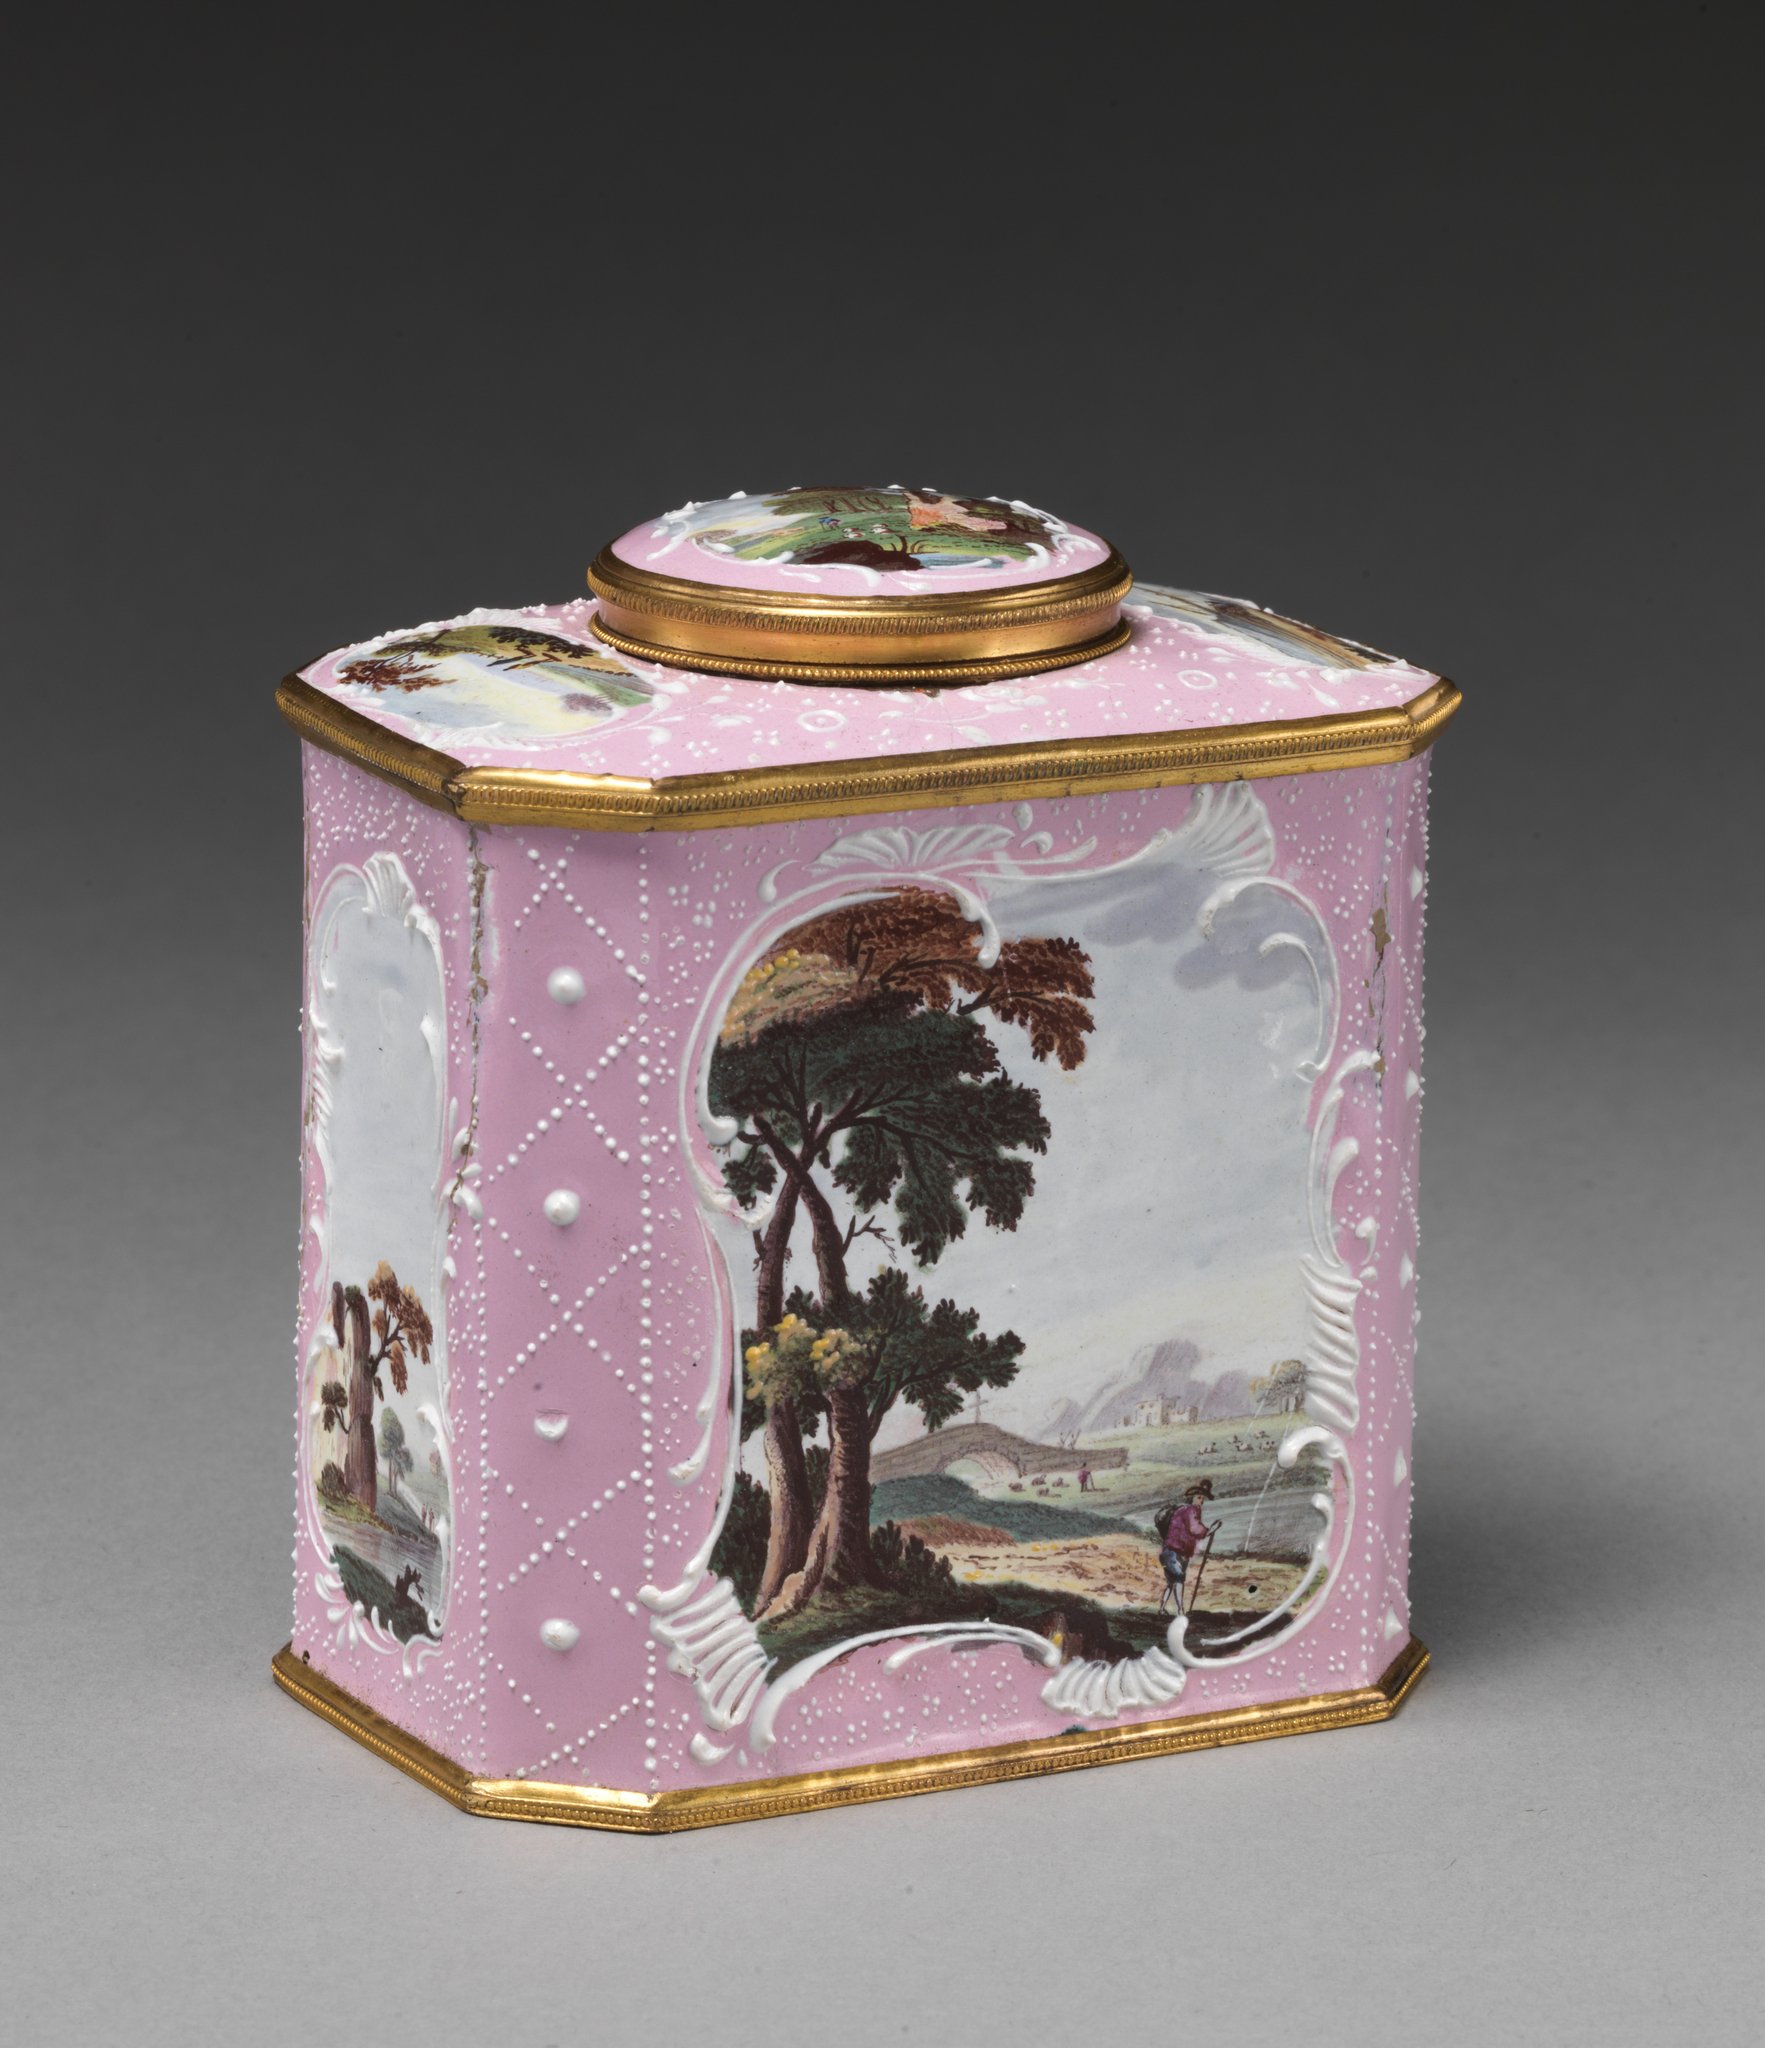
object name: tea caddy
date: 1765-1770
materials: copper, enamel